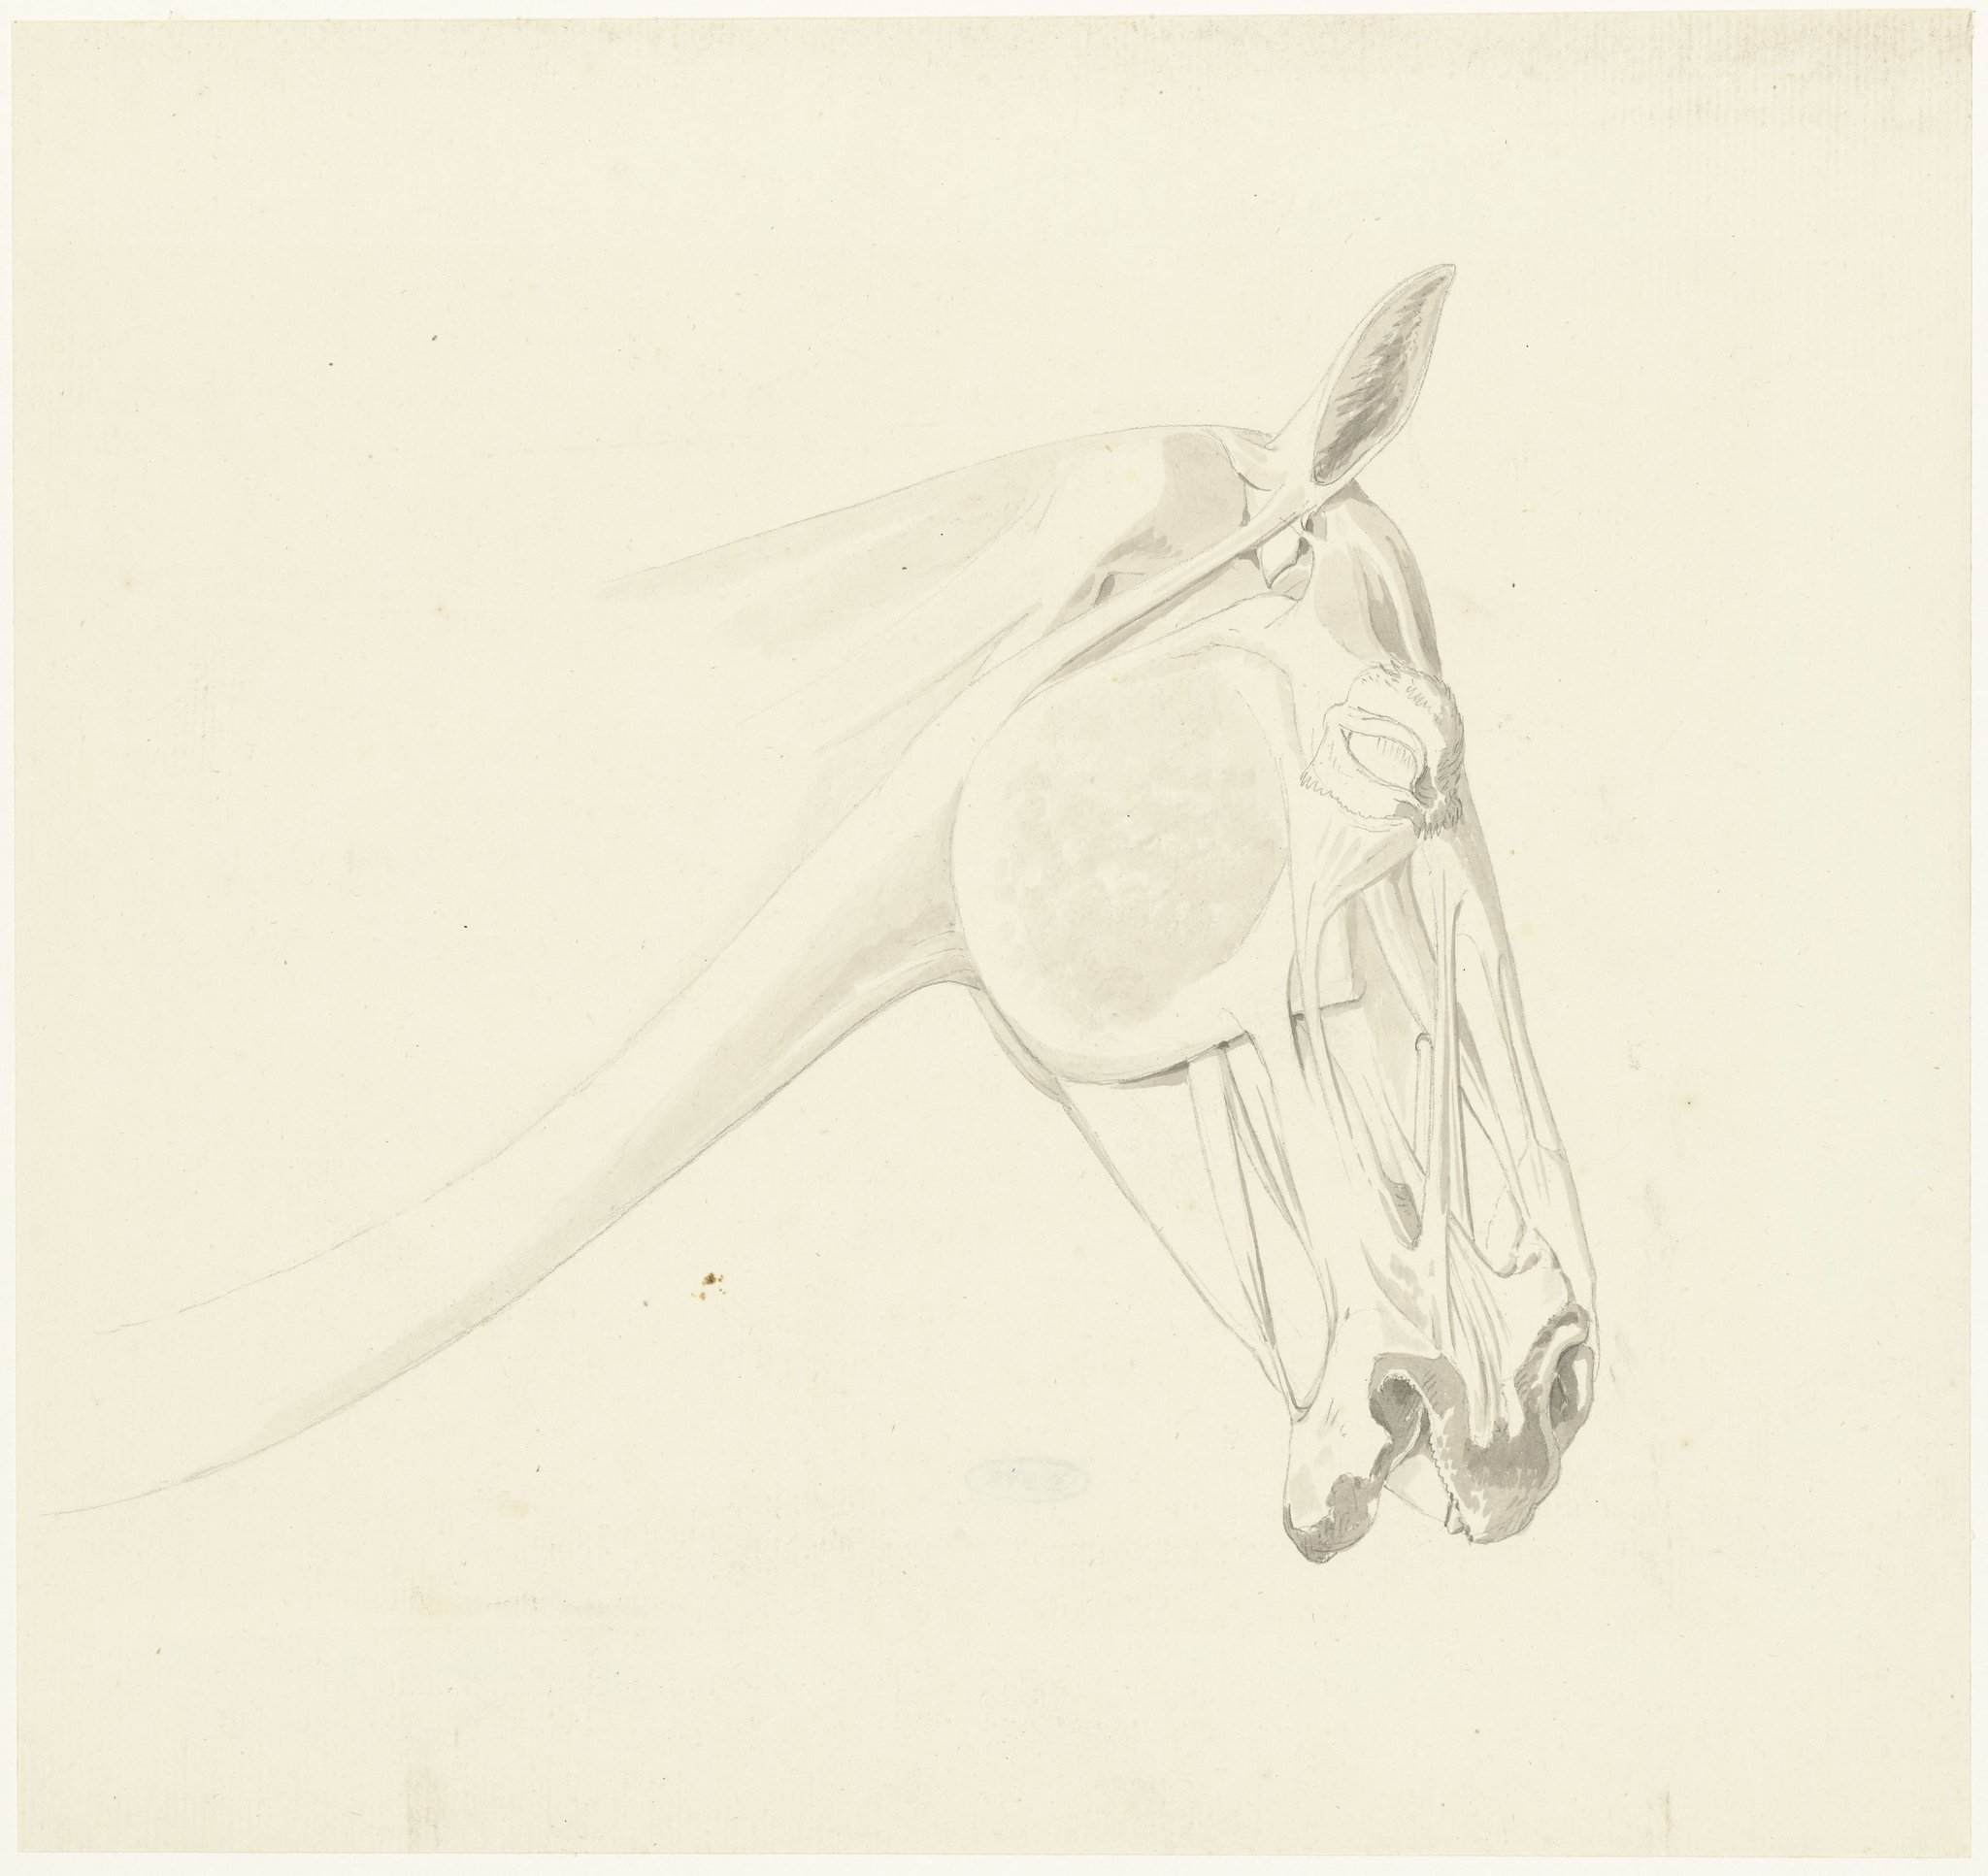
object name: drawing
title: Anatomische studie van de spieren van een paardenhoofd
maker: josephus augustus knip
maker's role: draughtsman, painter, print maker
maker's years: 1777-1847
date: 1787-1847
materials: paper, pencil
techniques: brush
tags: horse (+ head of an animal)